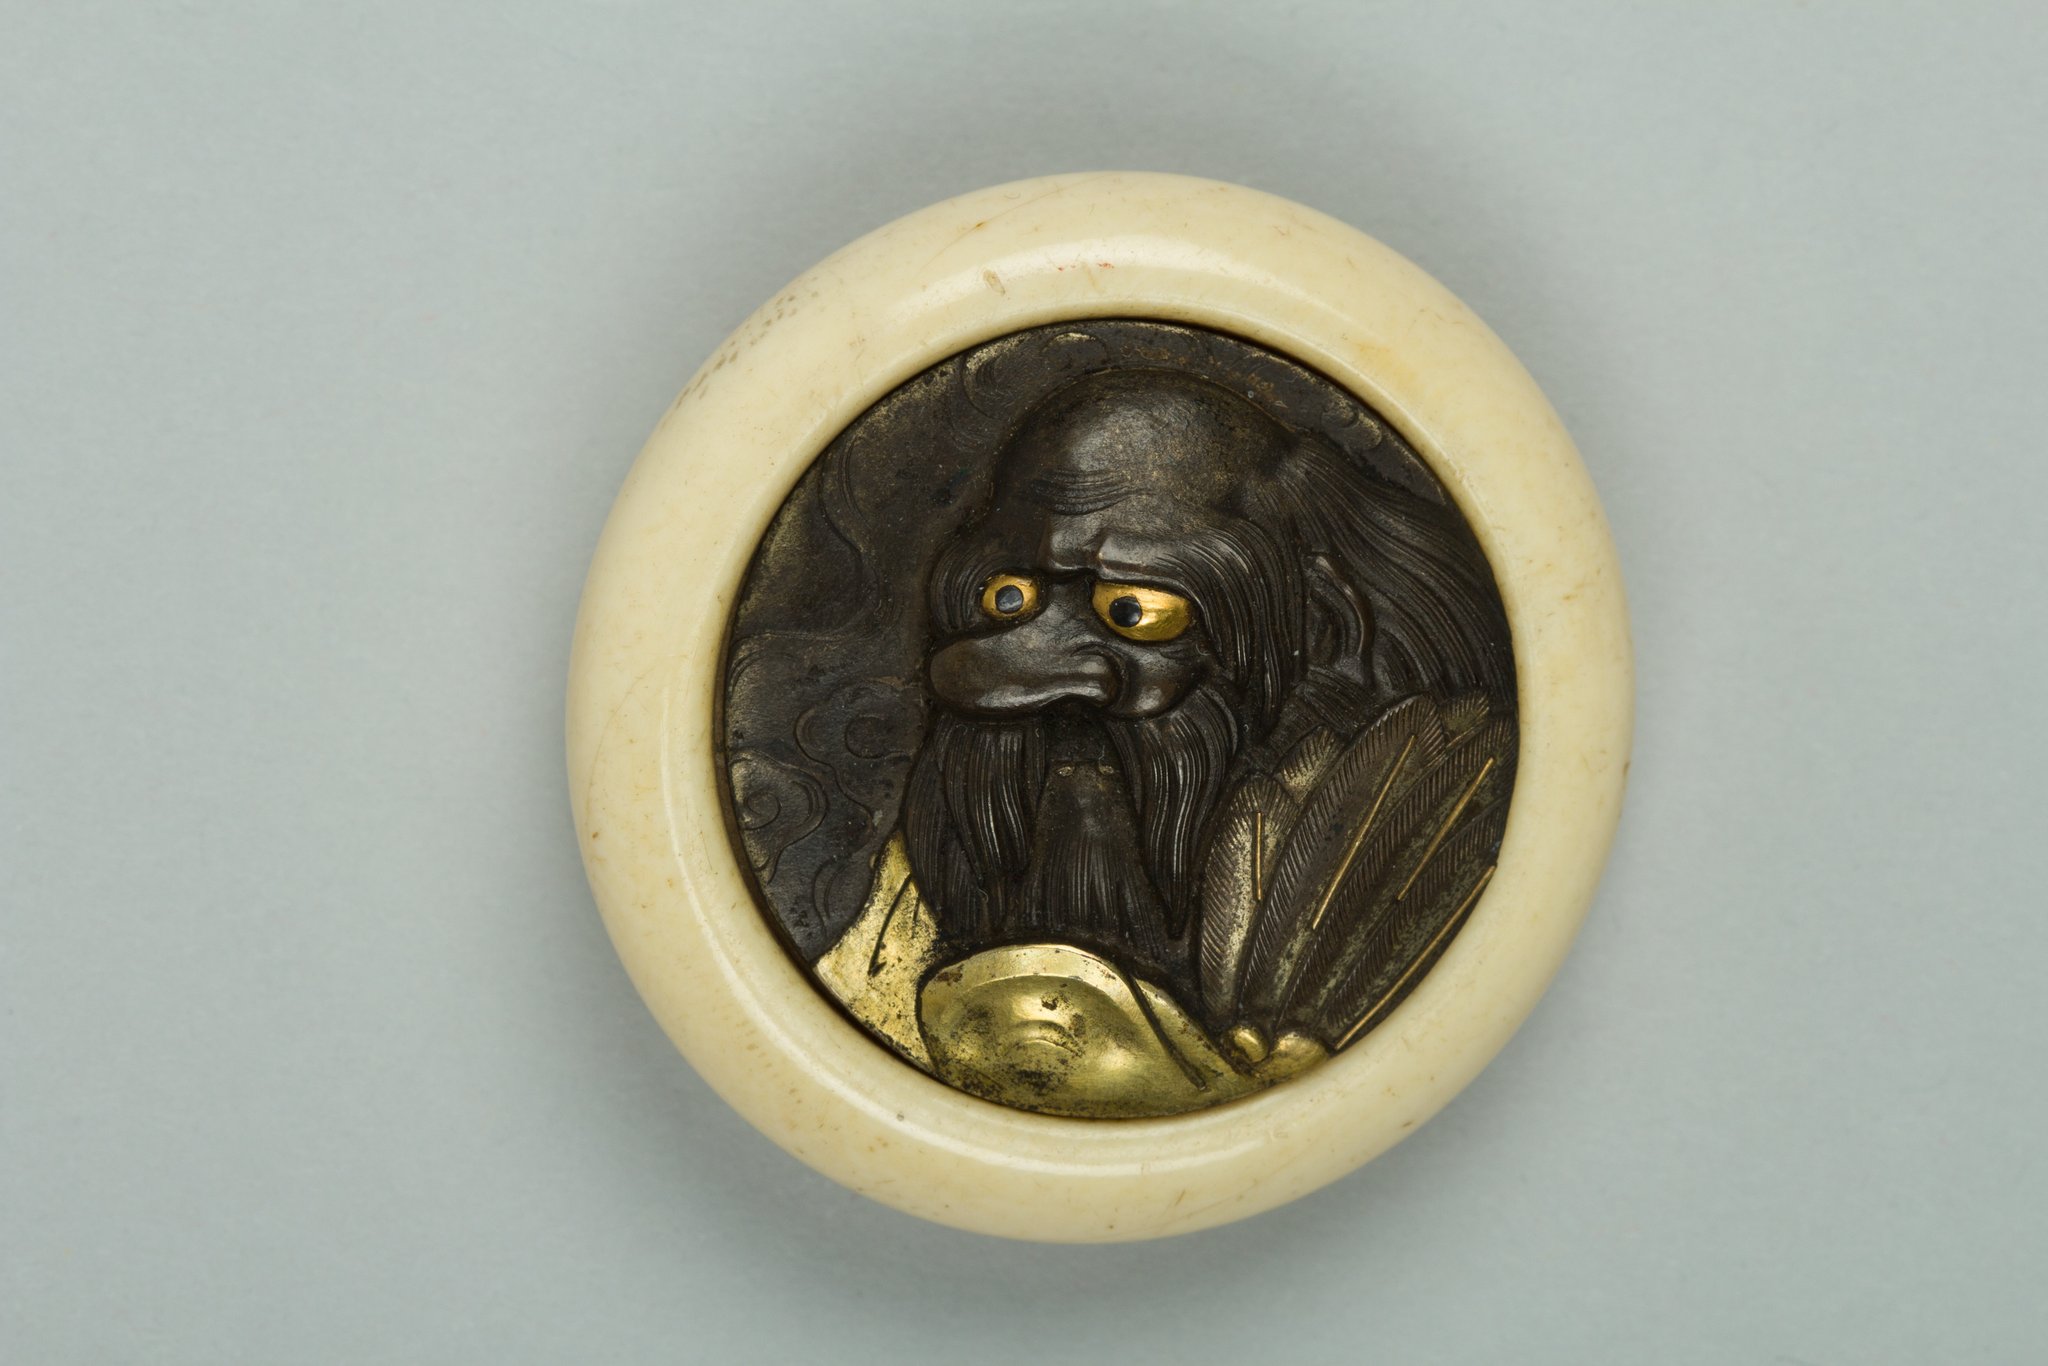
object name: netsuke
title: Netsuke of Sage with Big Nose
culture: japanese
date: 1801-1900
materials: ivory, metal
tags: men